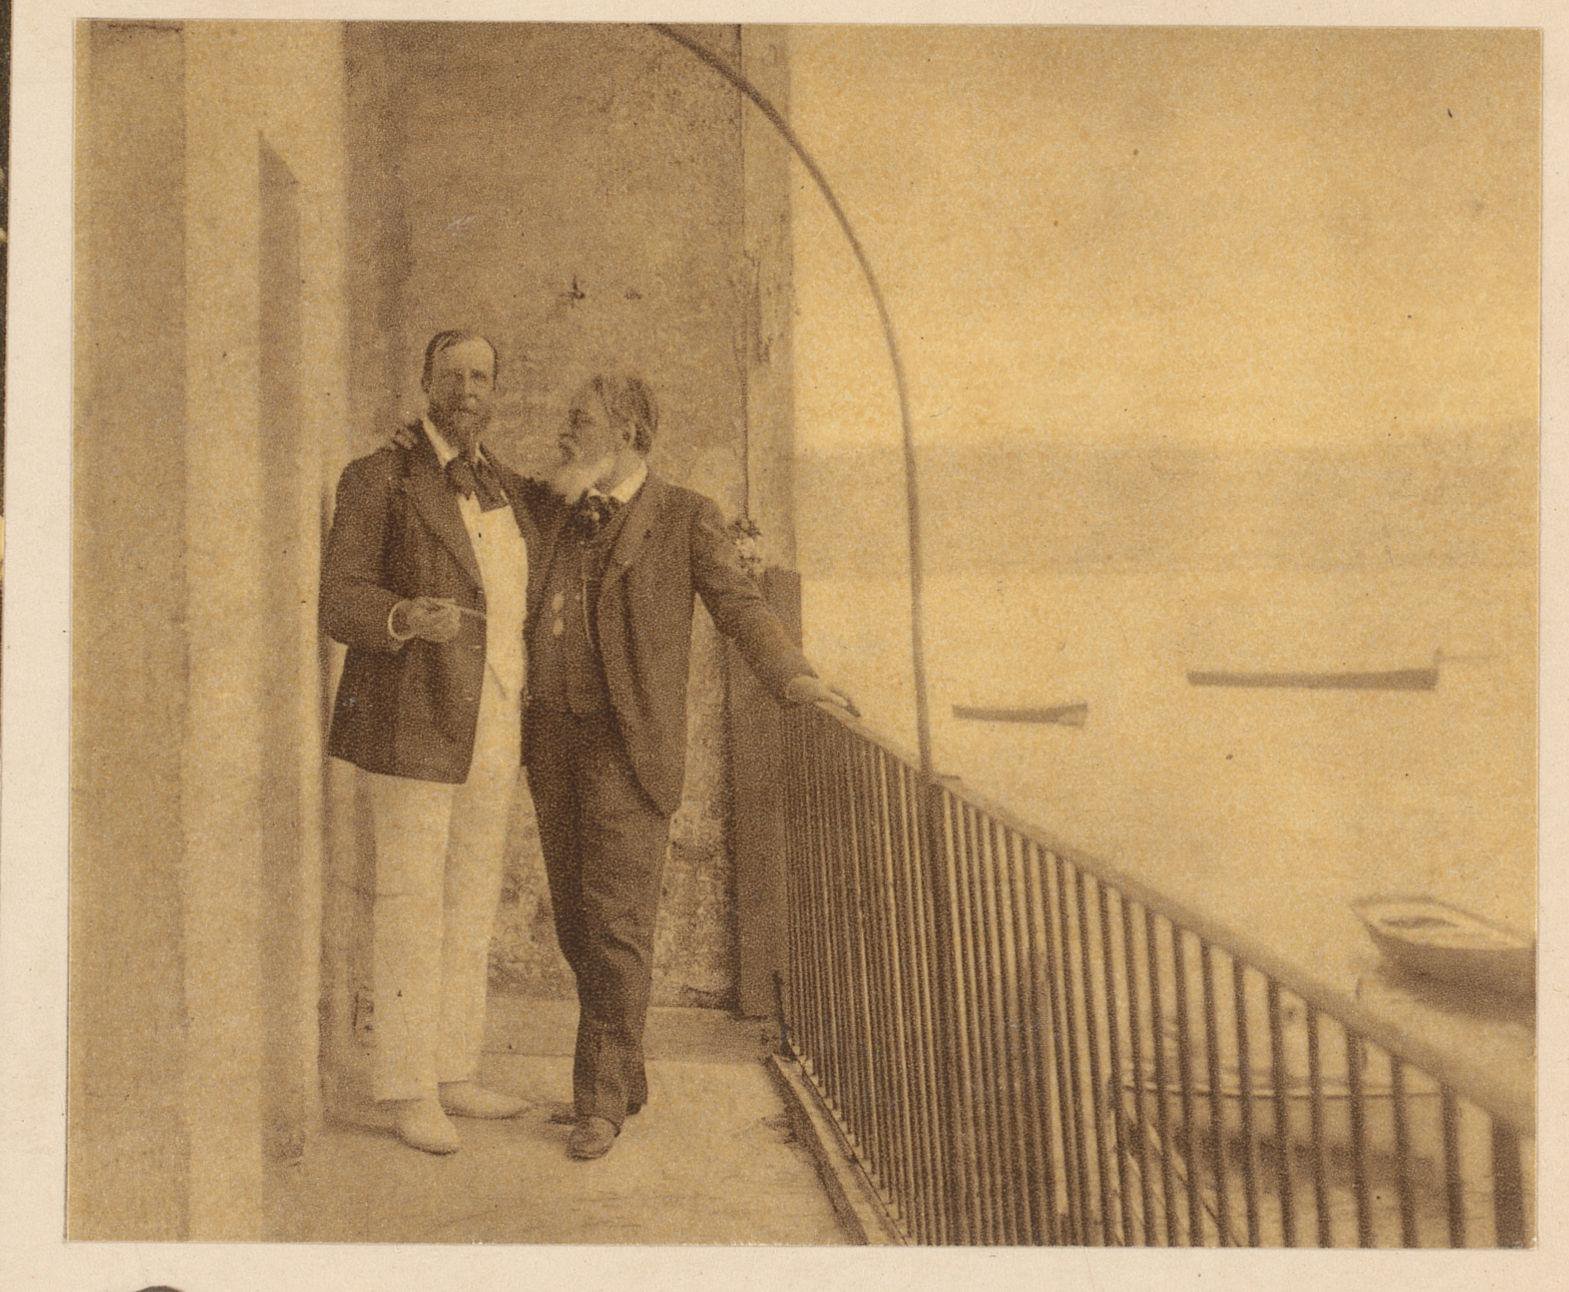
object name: album leaf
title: Déroulède et Mounet-Sully (en 1899)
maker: Anonymous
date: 1899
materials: paper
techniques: rotogravure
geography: france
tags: politician, paris, politician, e.g. party leader, portrait of actor, actress, france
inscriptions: inscription: ‘Fin du second album’